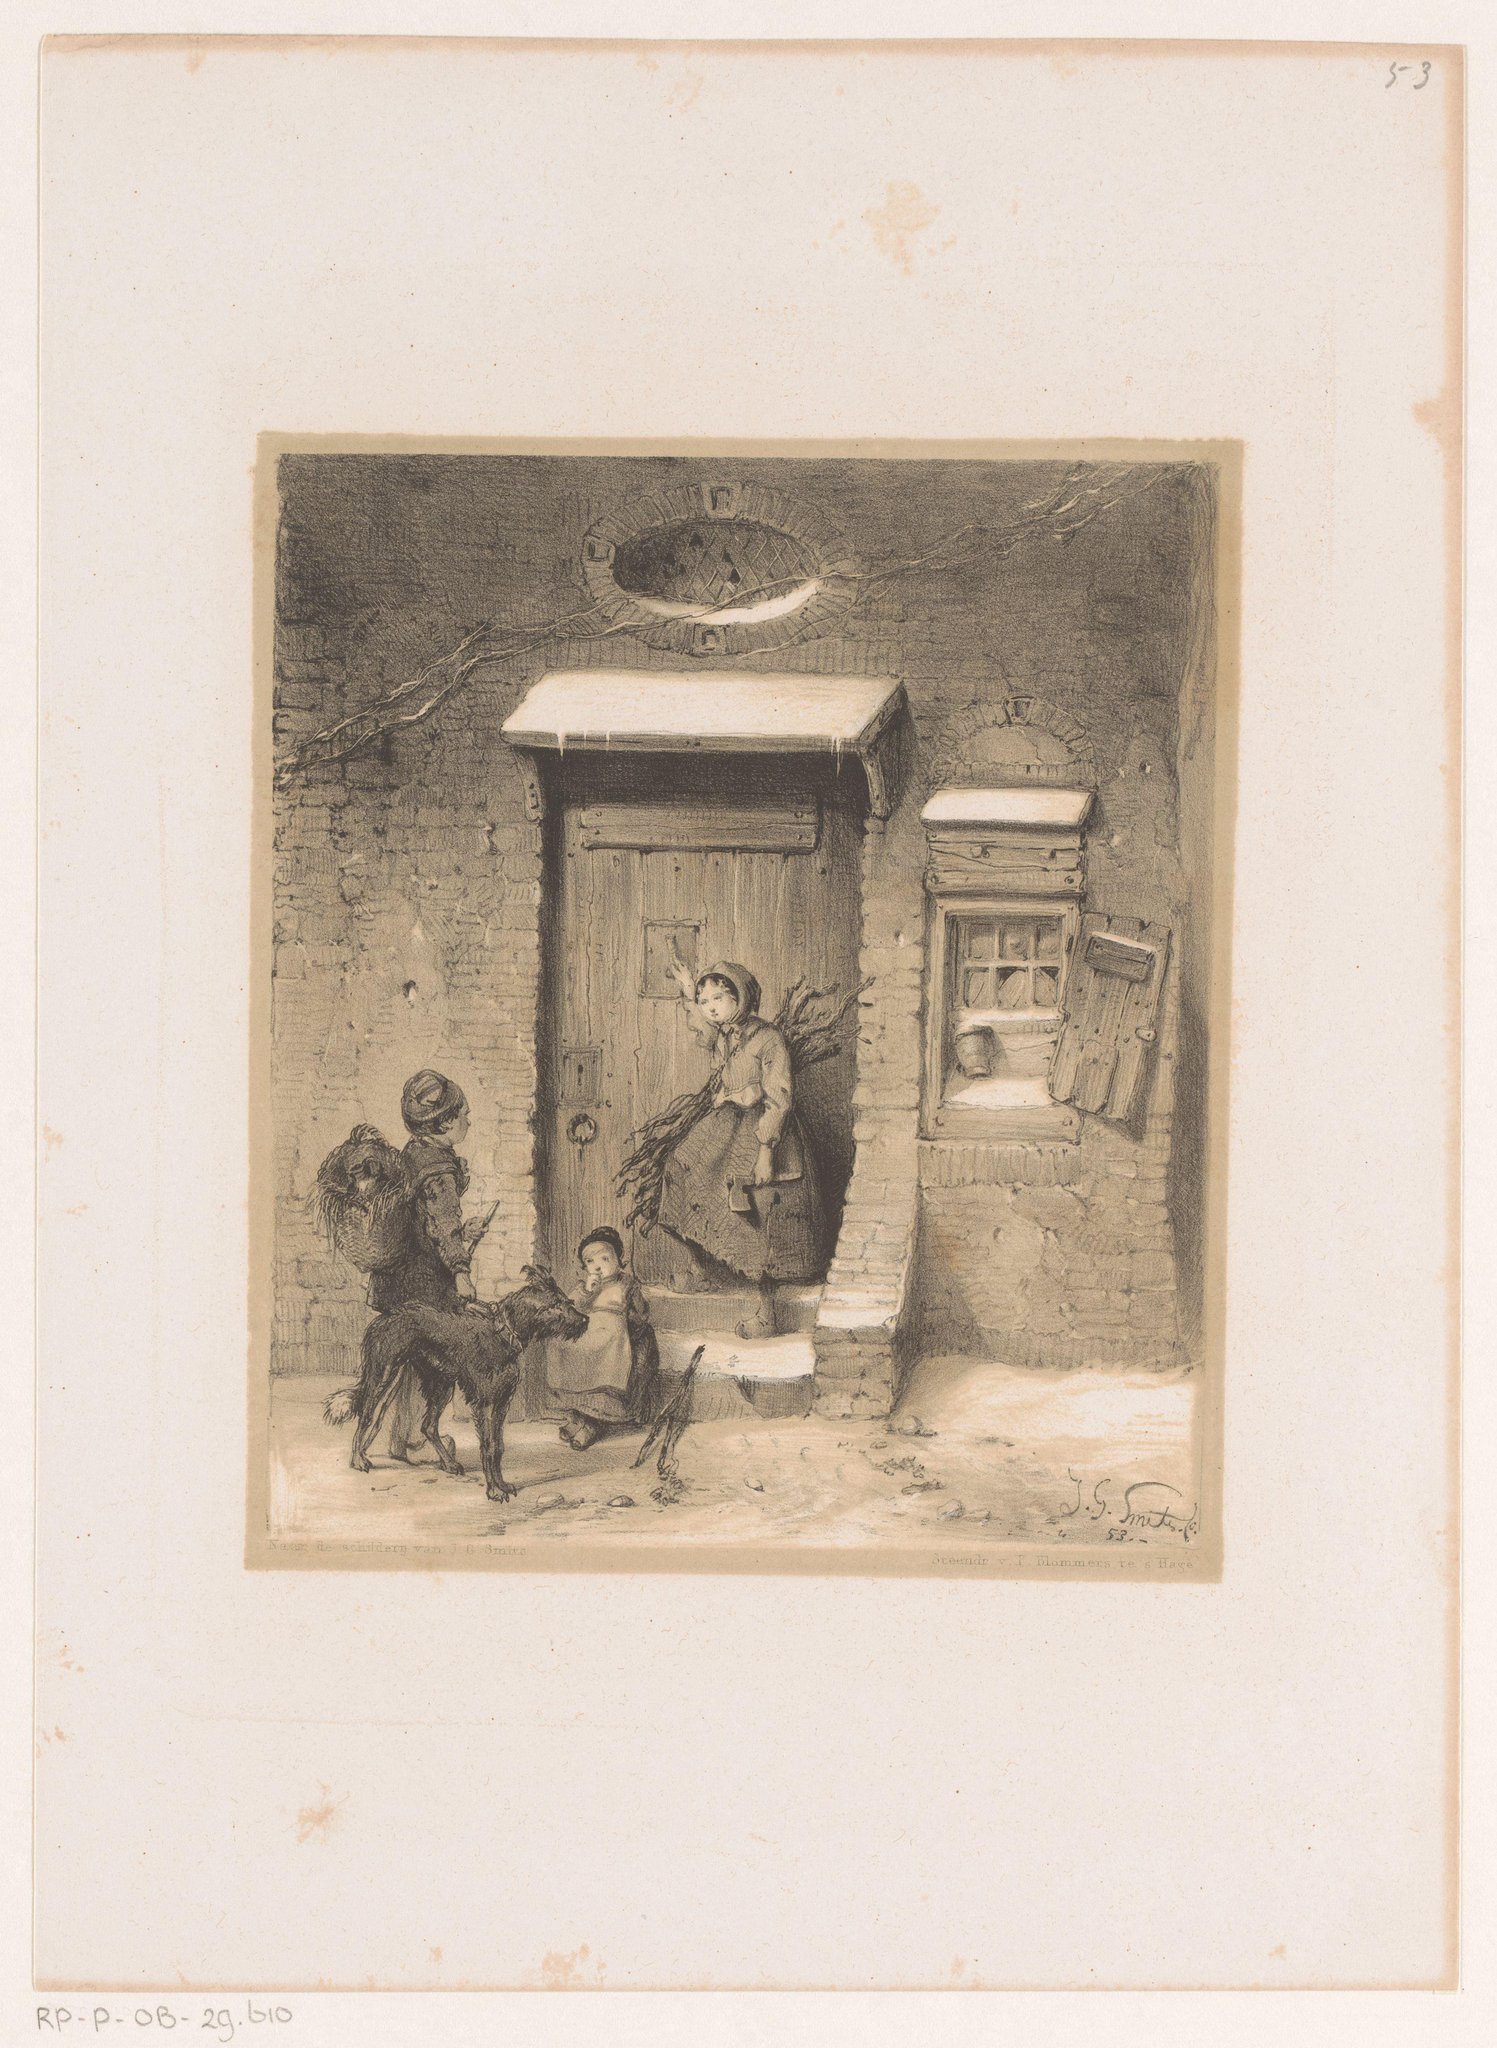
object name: print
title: Kinderen kloppen op buitendeur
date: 1853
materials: paper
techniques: tone lithography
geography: the hague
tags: knocking at the door, woodgathering, woodgatherer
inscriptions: collector's mark: Lugt 2228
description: Drie houtsprokkelende kinderen en hun hond bij een deur. Een meisje klopt aan